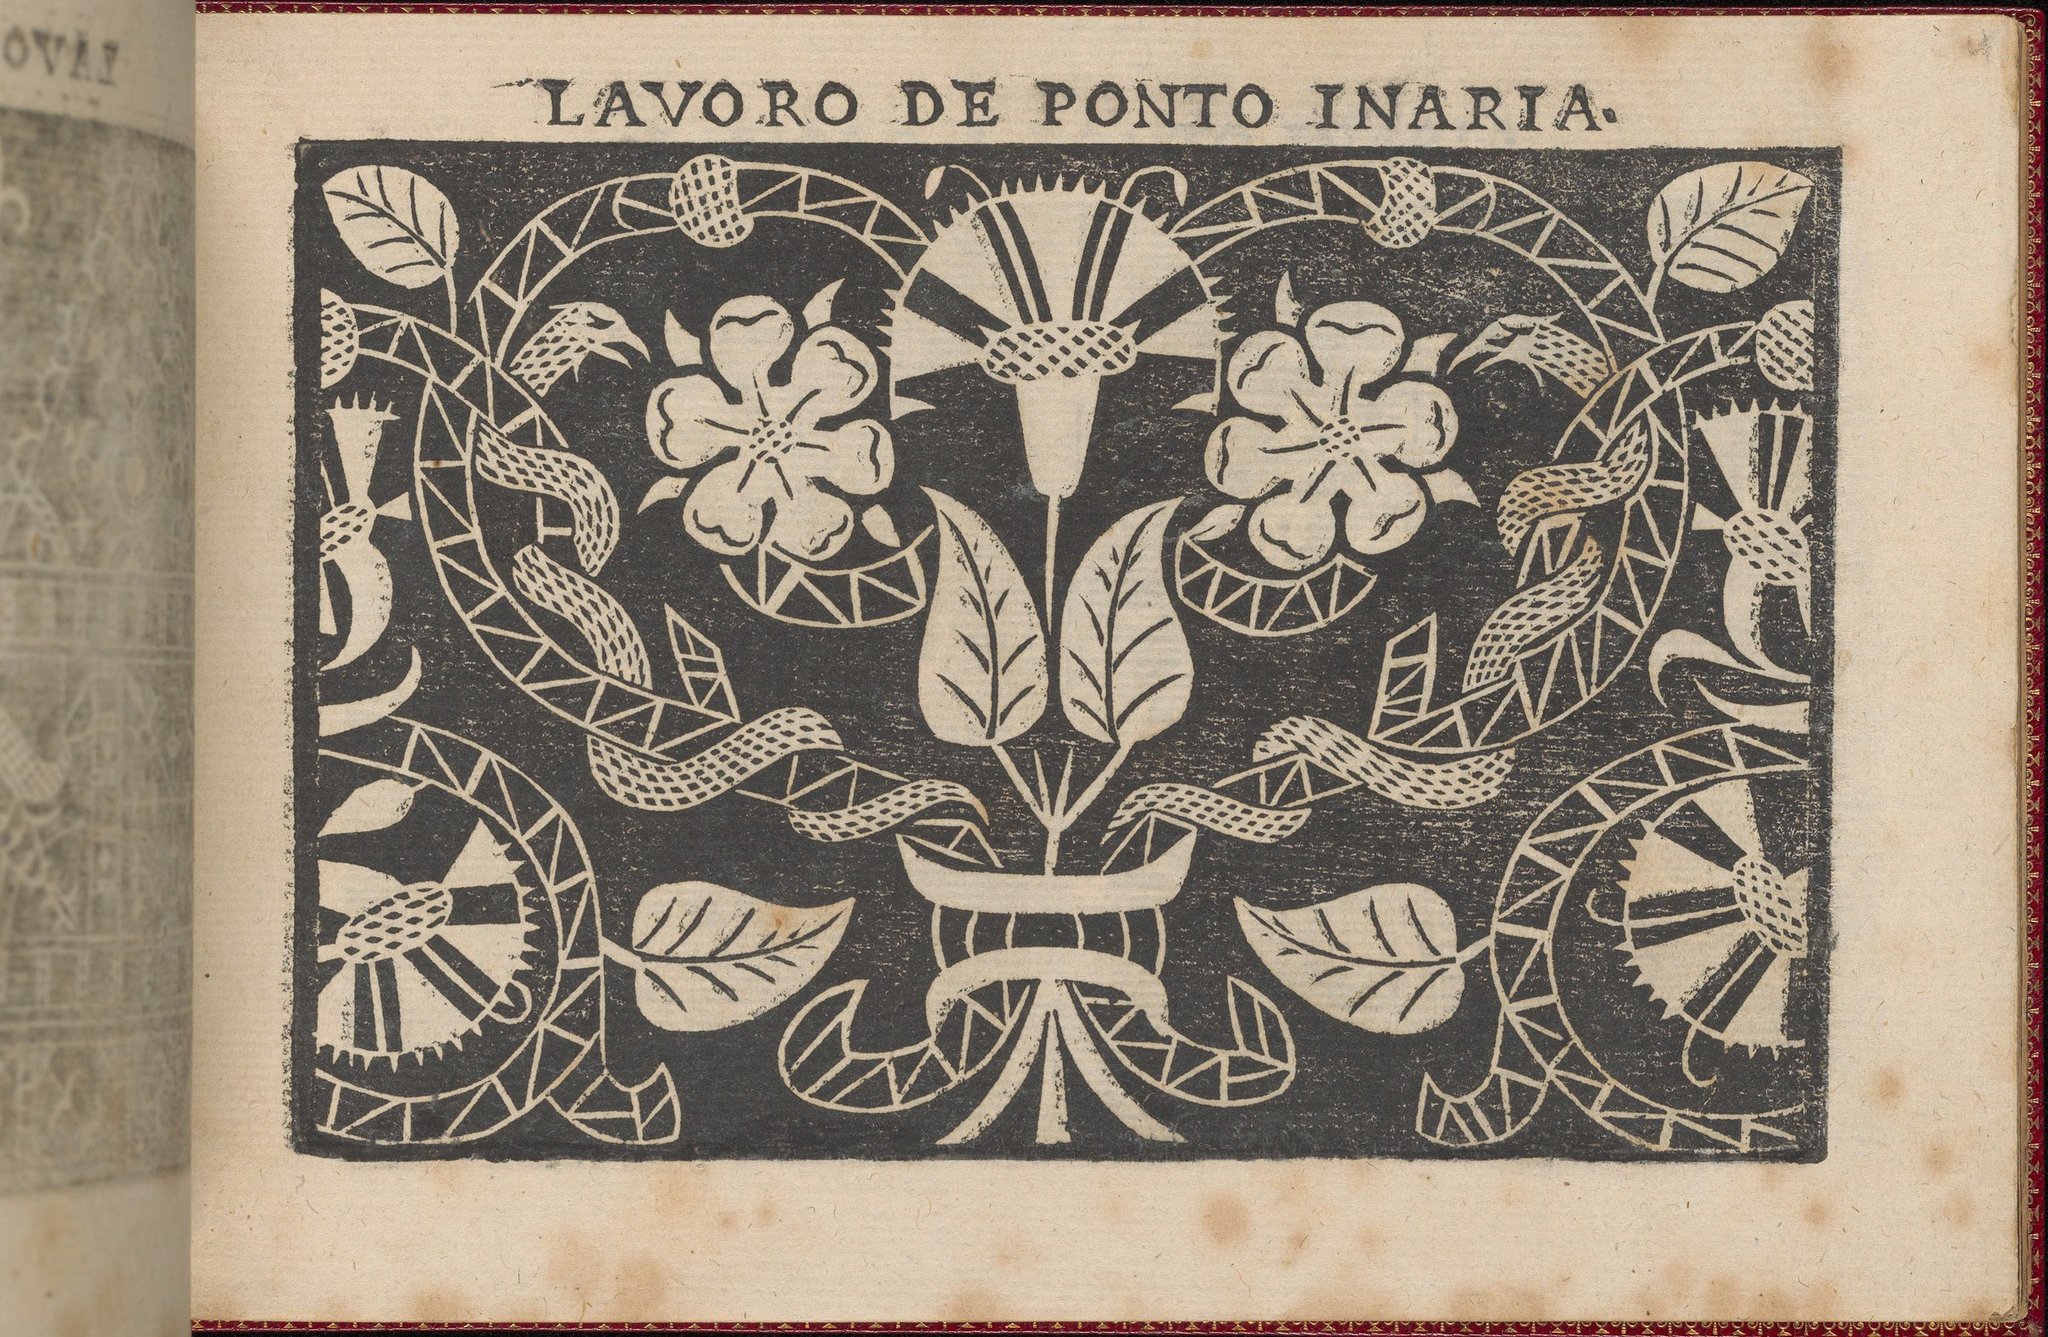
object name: book print ornament architecture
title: Pretiosa Gemma delle virtuose donne, page 6 (recto)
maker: isabella catanea parasole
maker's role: author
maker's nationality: italian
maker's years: 1565-1625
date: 1600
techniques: woodcut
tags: serpents,flowers,leaves